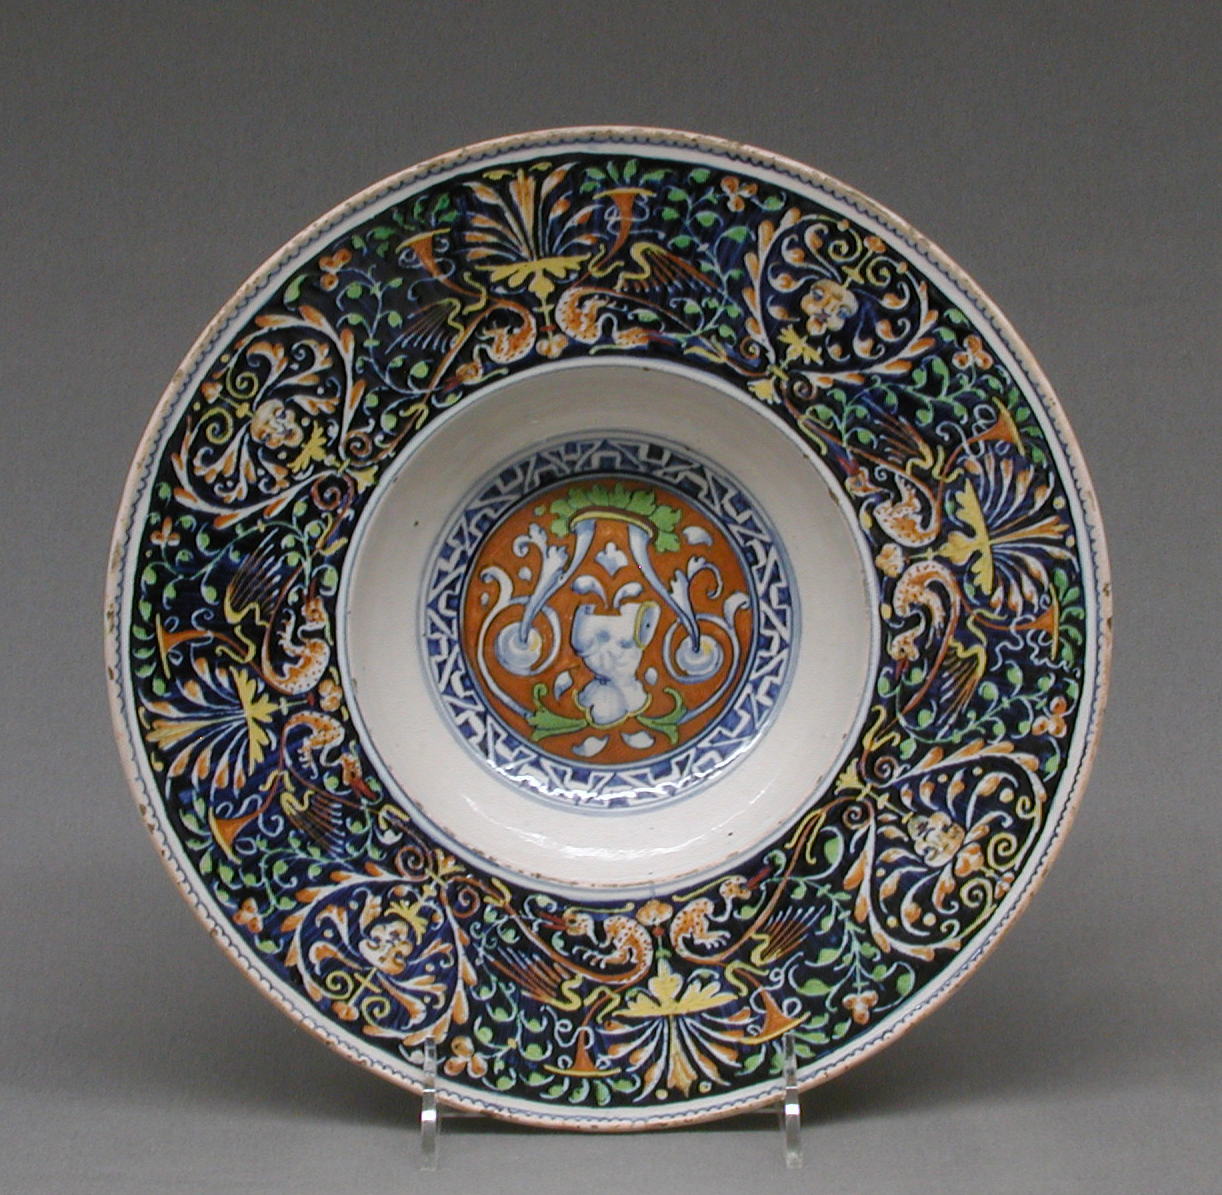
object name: plate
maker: the vulcan painter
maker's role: decorator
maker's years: 1475-1575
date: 1520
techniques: maiolica, glazing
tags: birds,armor